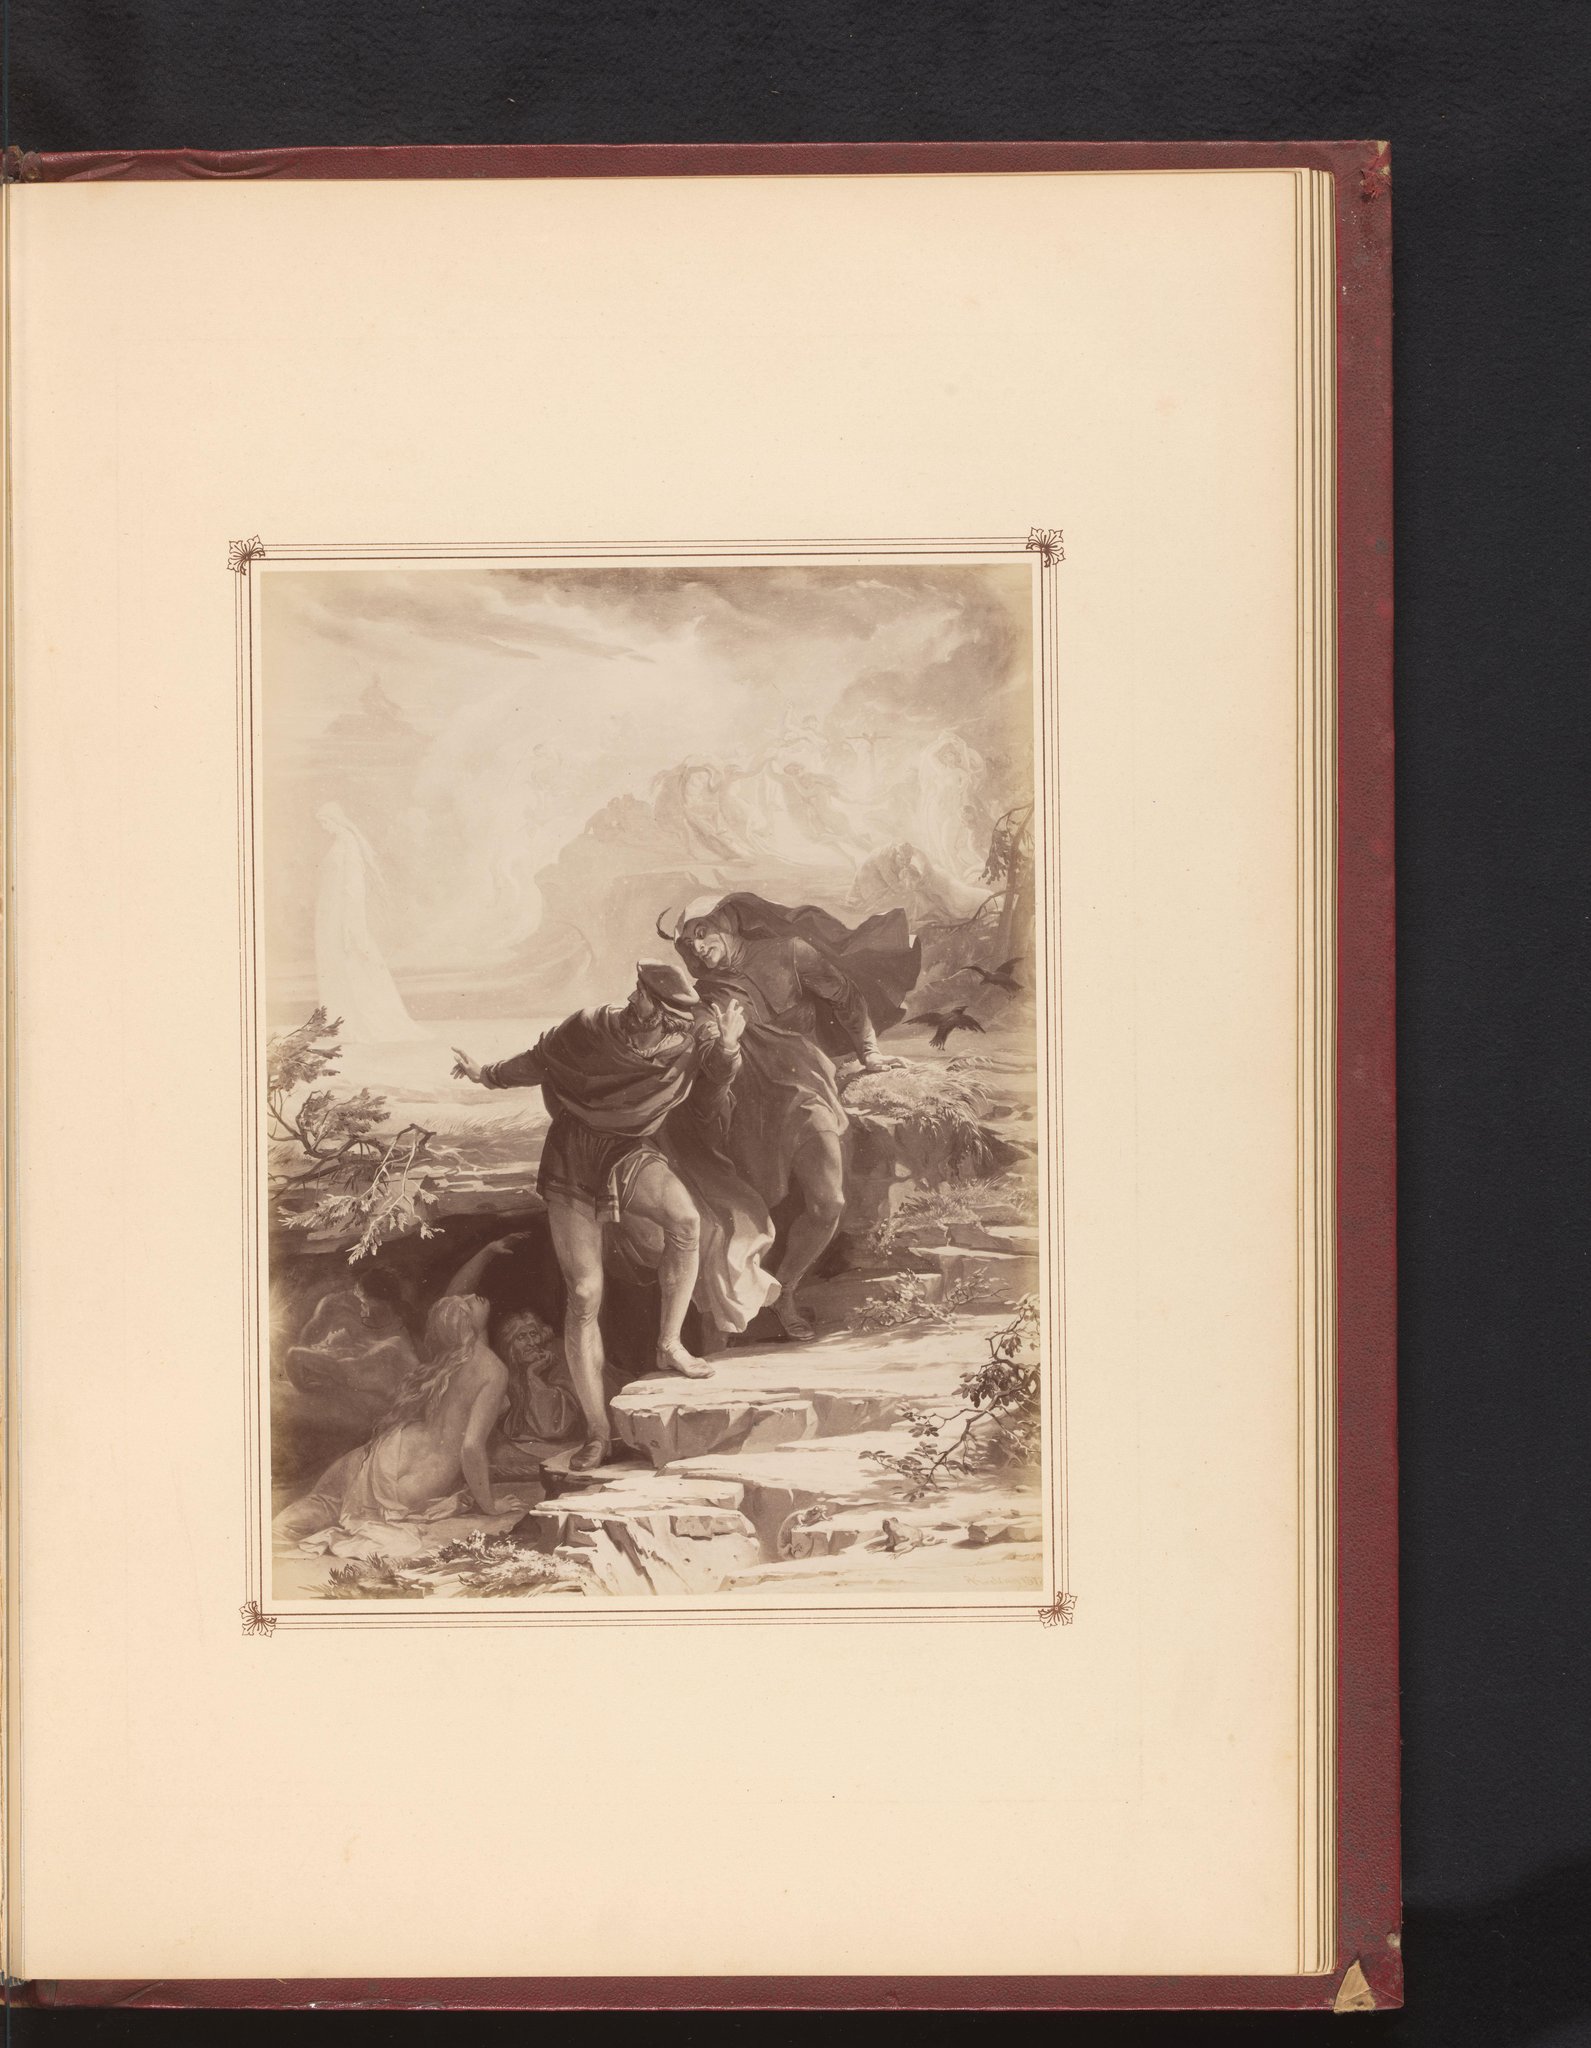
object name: photograph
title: Fotoreproductie van een tekening van Faust en Mephistopheles met op de achtergrond Gretchen, uit het eerste deel van de tragedie Faust door Johann Wolfgang von Goethe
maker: friedrich bruckmann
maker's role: publisher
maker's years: 1814-1898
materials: photographic support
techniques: albumen print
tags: mephistopheles, name of the demonic tempter in the literary versions of the faust legends, (scenes from) specific works of literature: goethe, faust